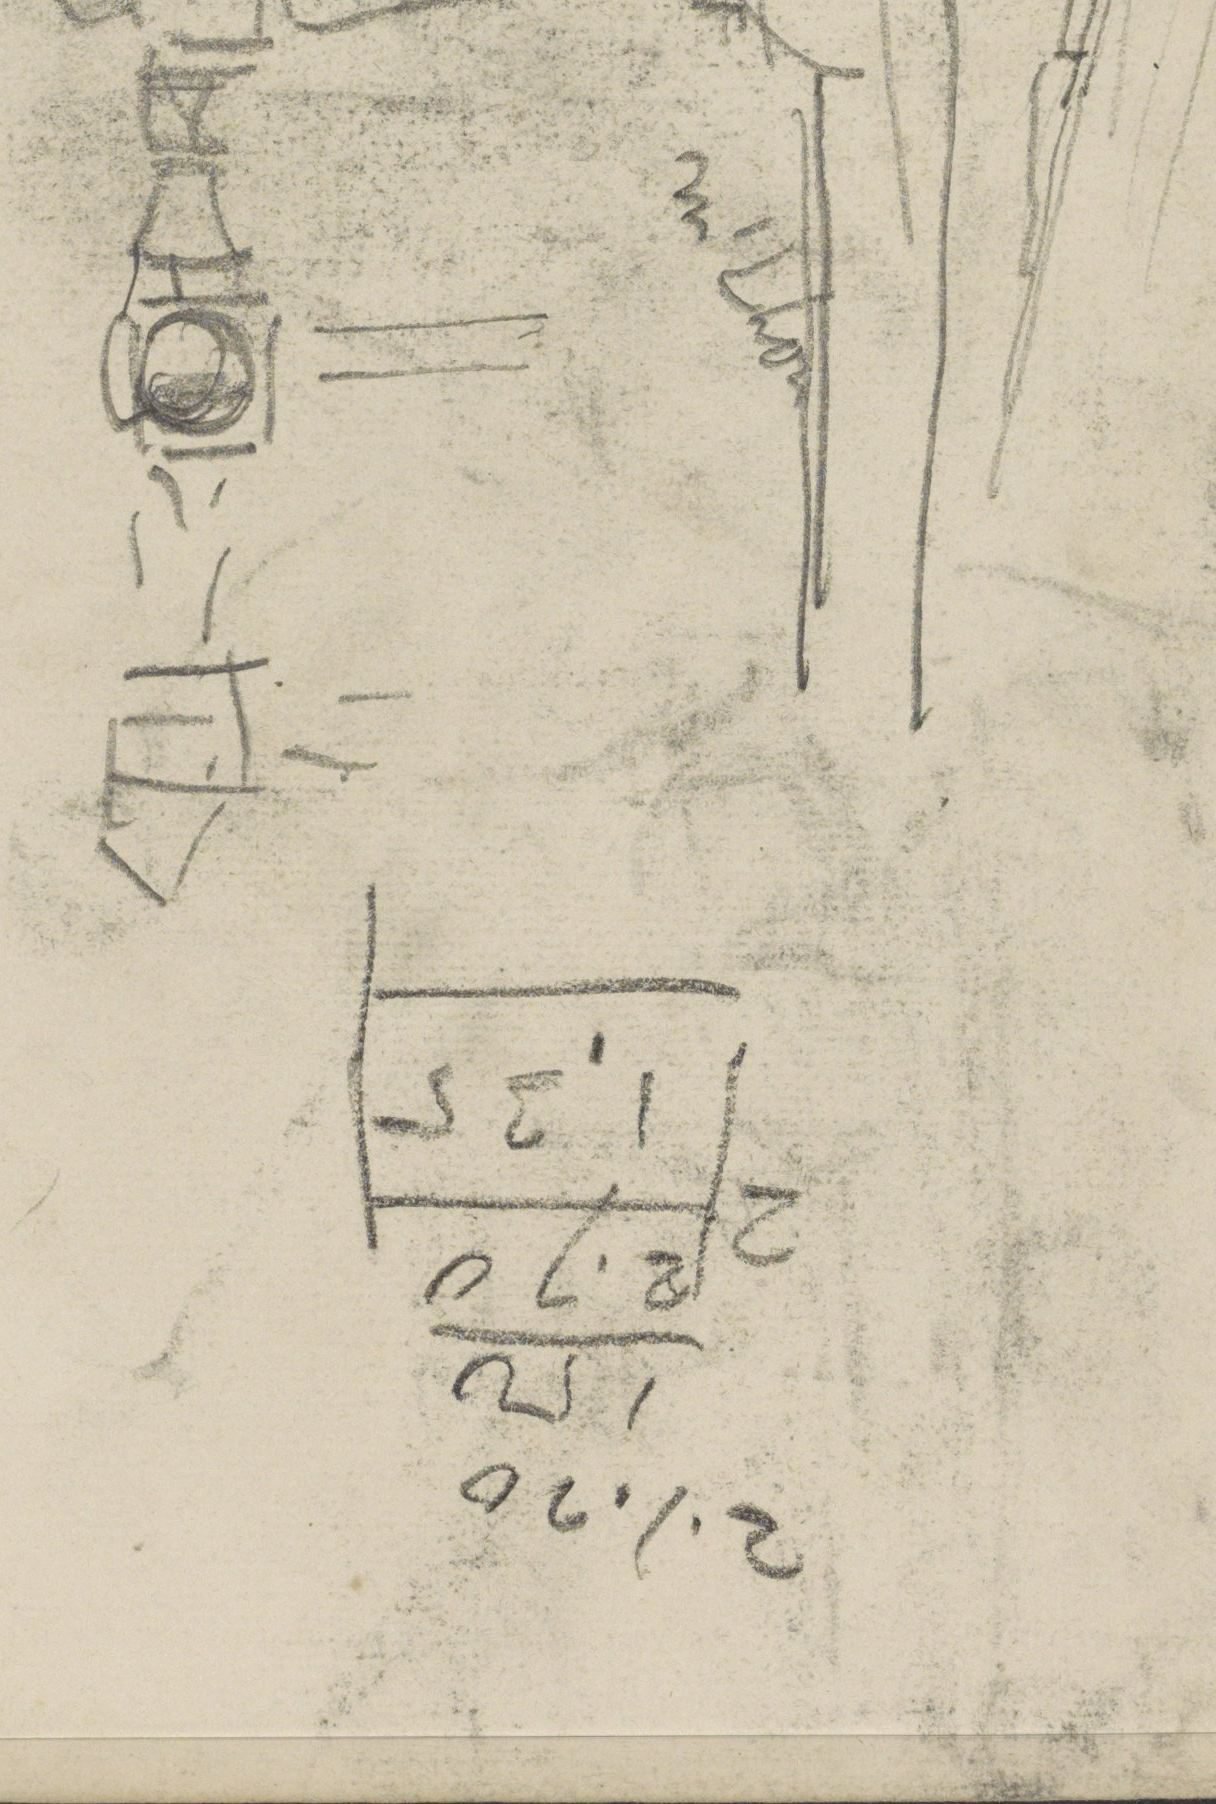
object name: sketchbook leaf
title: Meubel, mogelijk een tafel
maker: george hendrik breitner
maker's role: draughtsman, painter, print maker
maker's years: 1857-1923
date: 1886-1923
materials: paper, pencil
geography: amsterdam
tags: table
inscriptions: annotation: ‘[...]’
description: Pagina 54 uit een schetsboek met 19 bladen en 9 losse tekeningen.